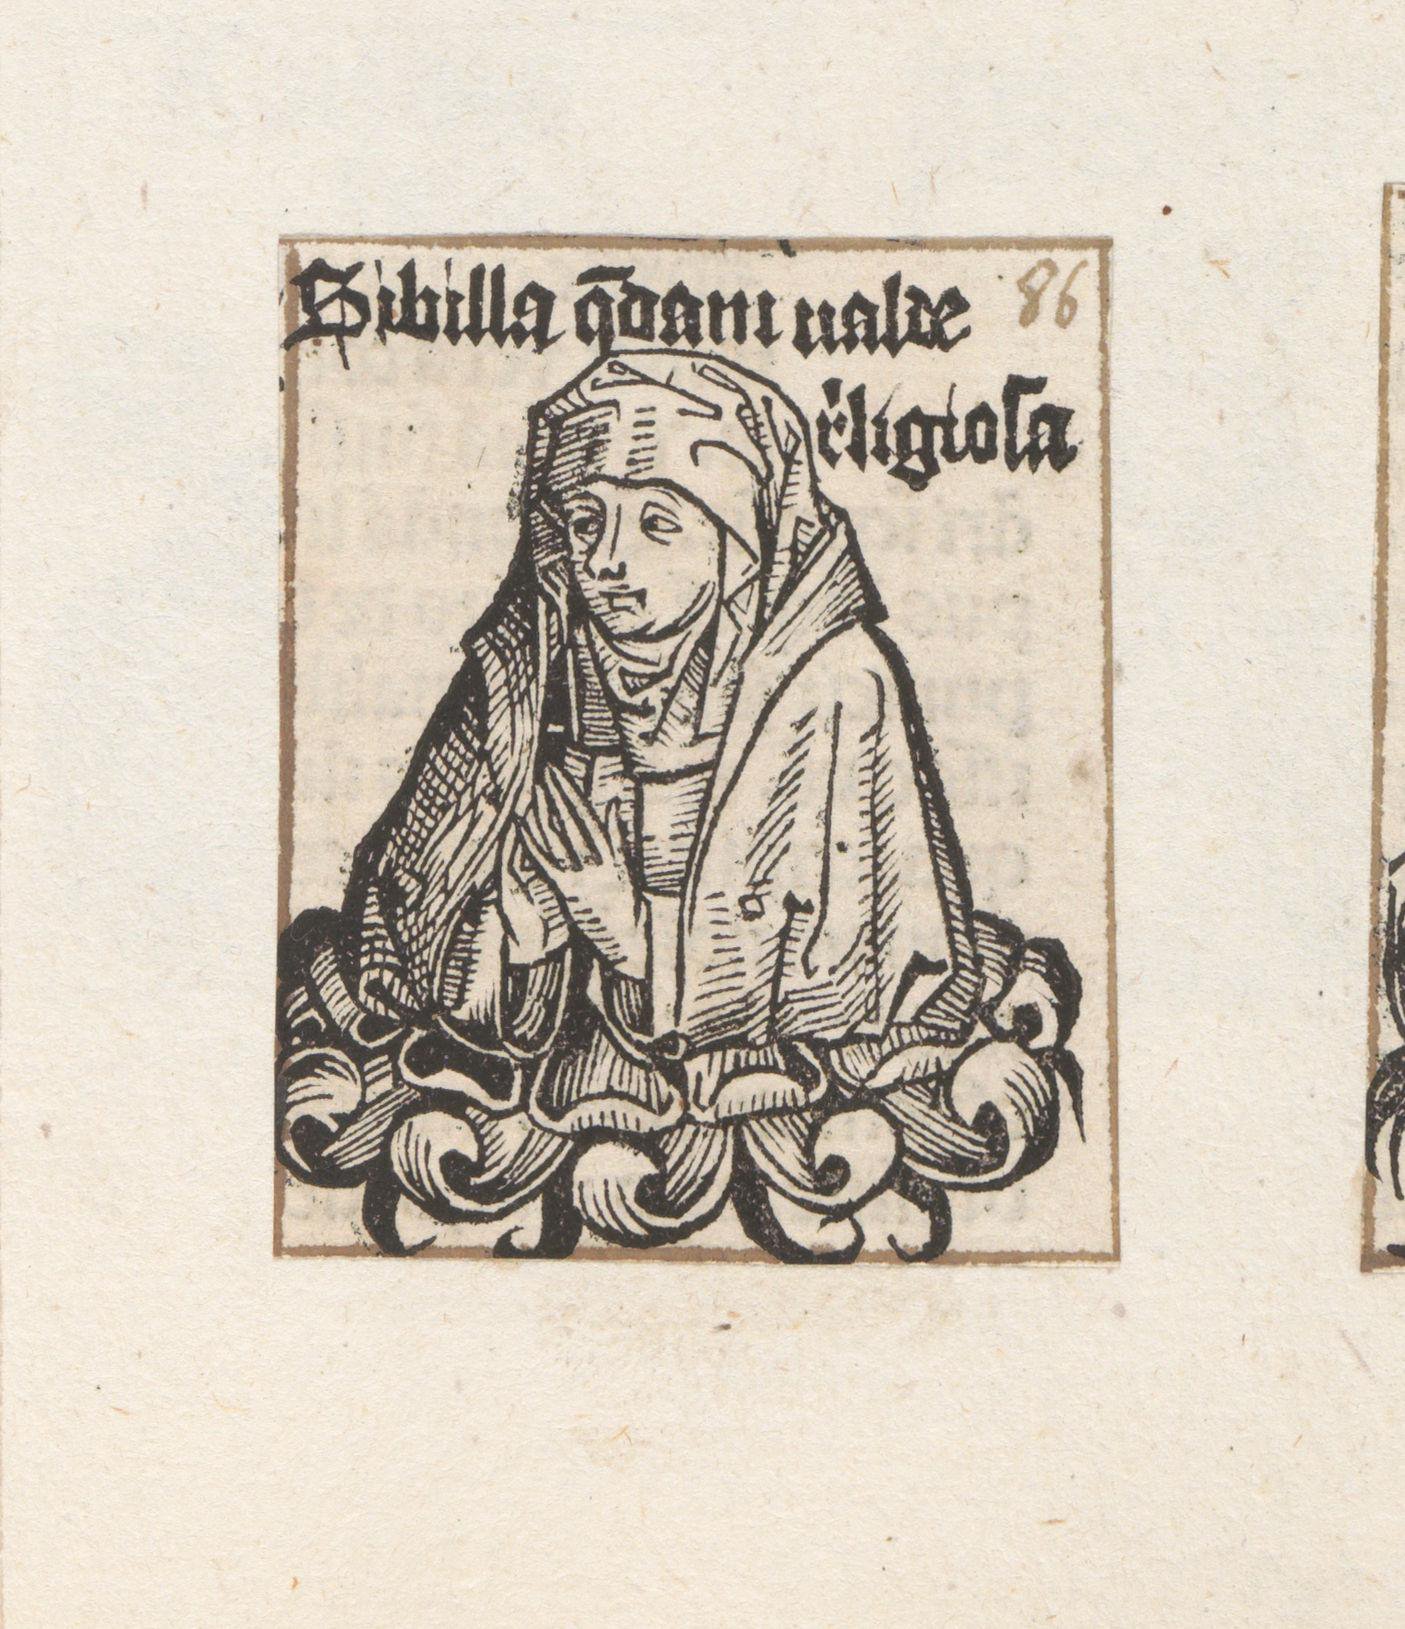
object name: album leaf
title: Religieuze Sibille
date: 1493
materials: paper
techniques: letterpress printing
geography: nuremberg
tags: sibyls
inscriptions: inscription: ‘86’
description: De houtsnede wordt gebruikt als boekillustratie in de Liber Chronicarum (of Neurenbergkroniek) van Hartmann Schedel, verschenen in het Latijn en Duits in 1493. Zie de Latijnse uitgave, folio 35v.